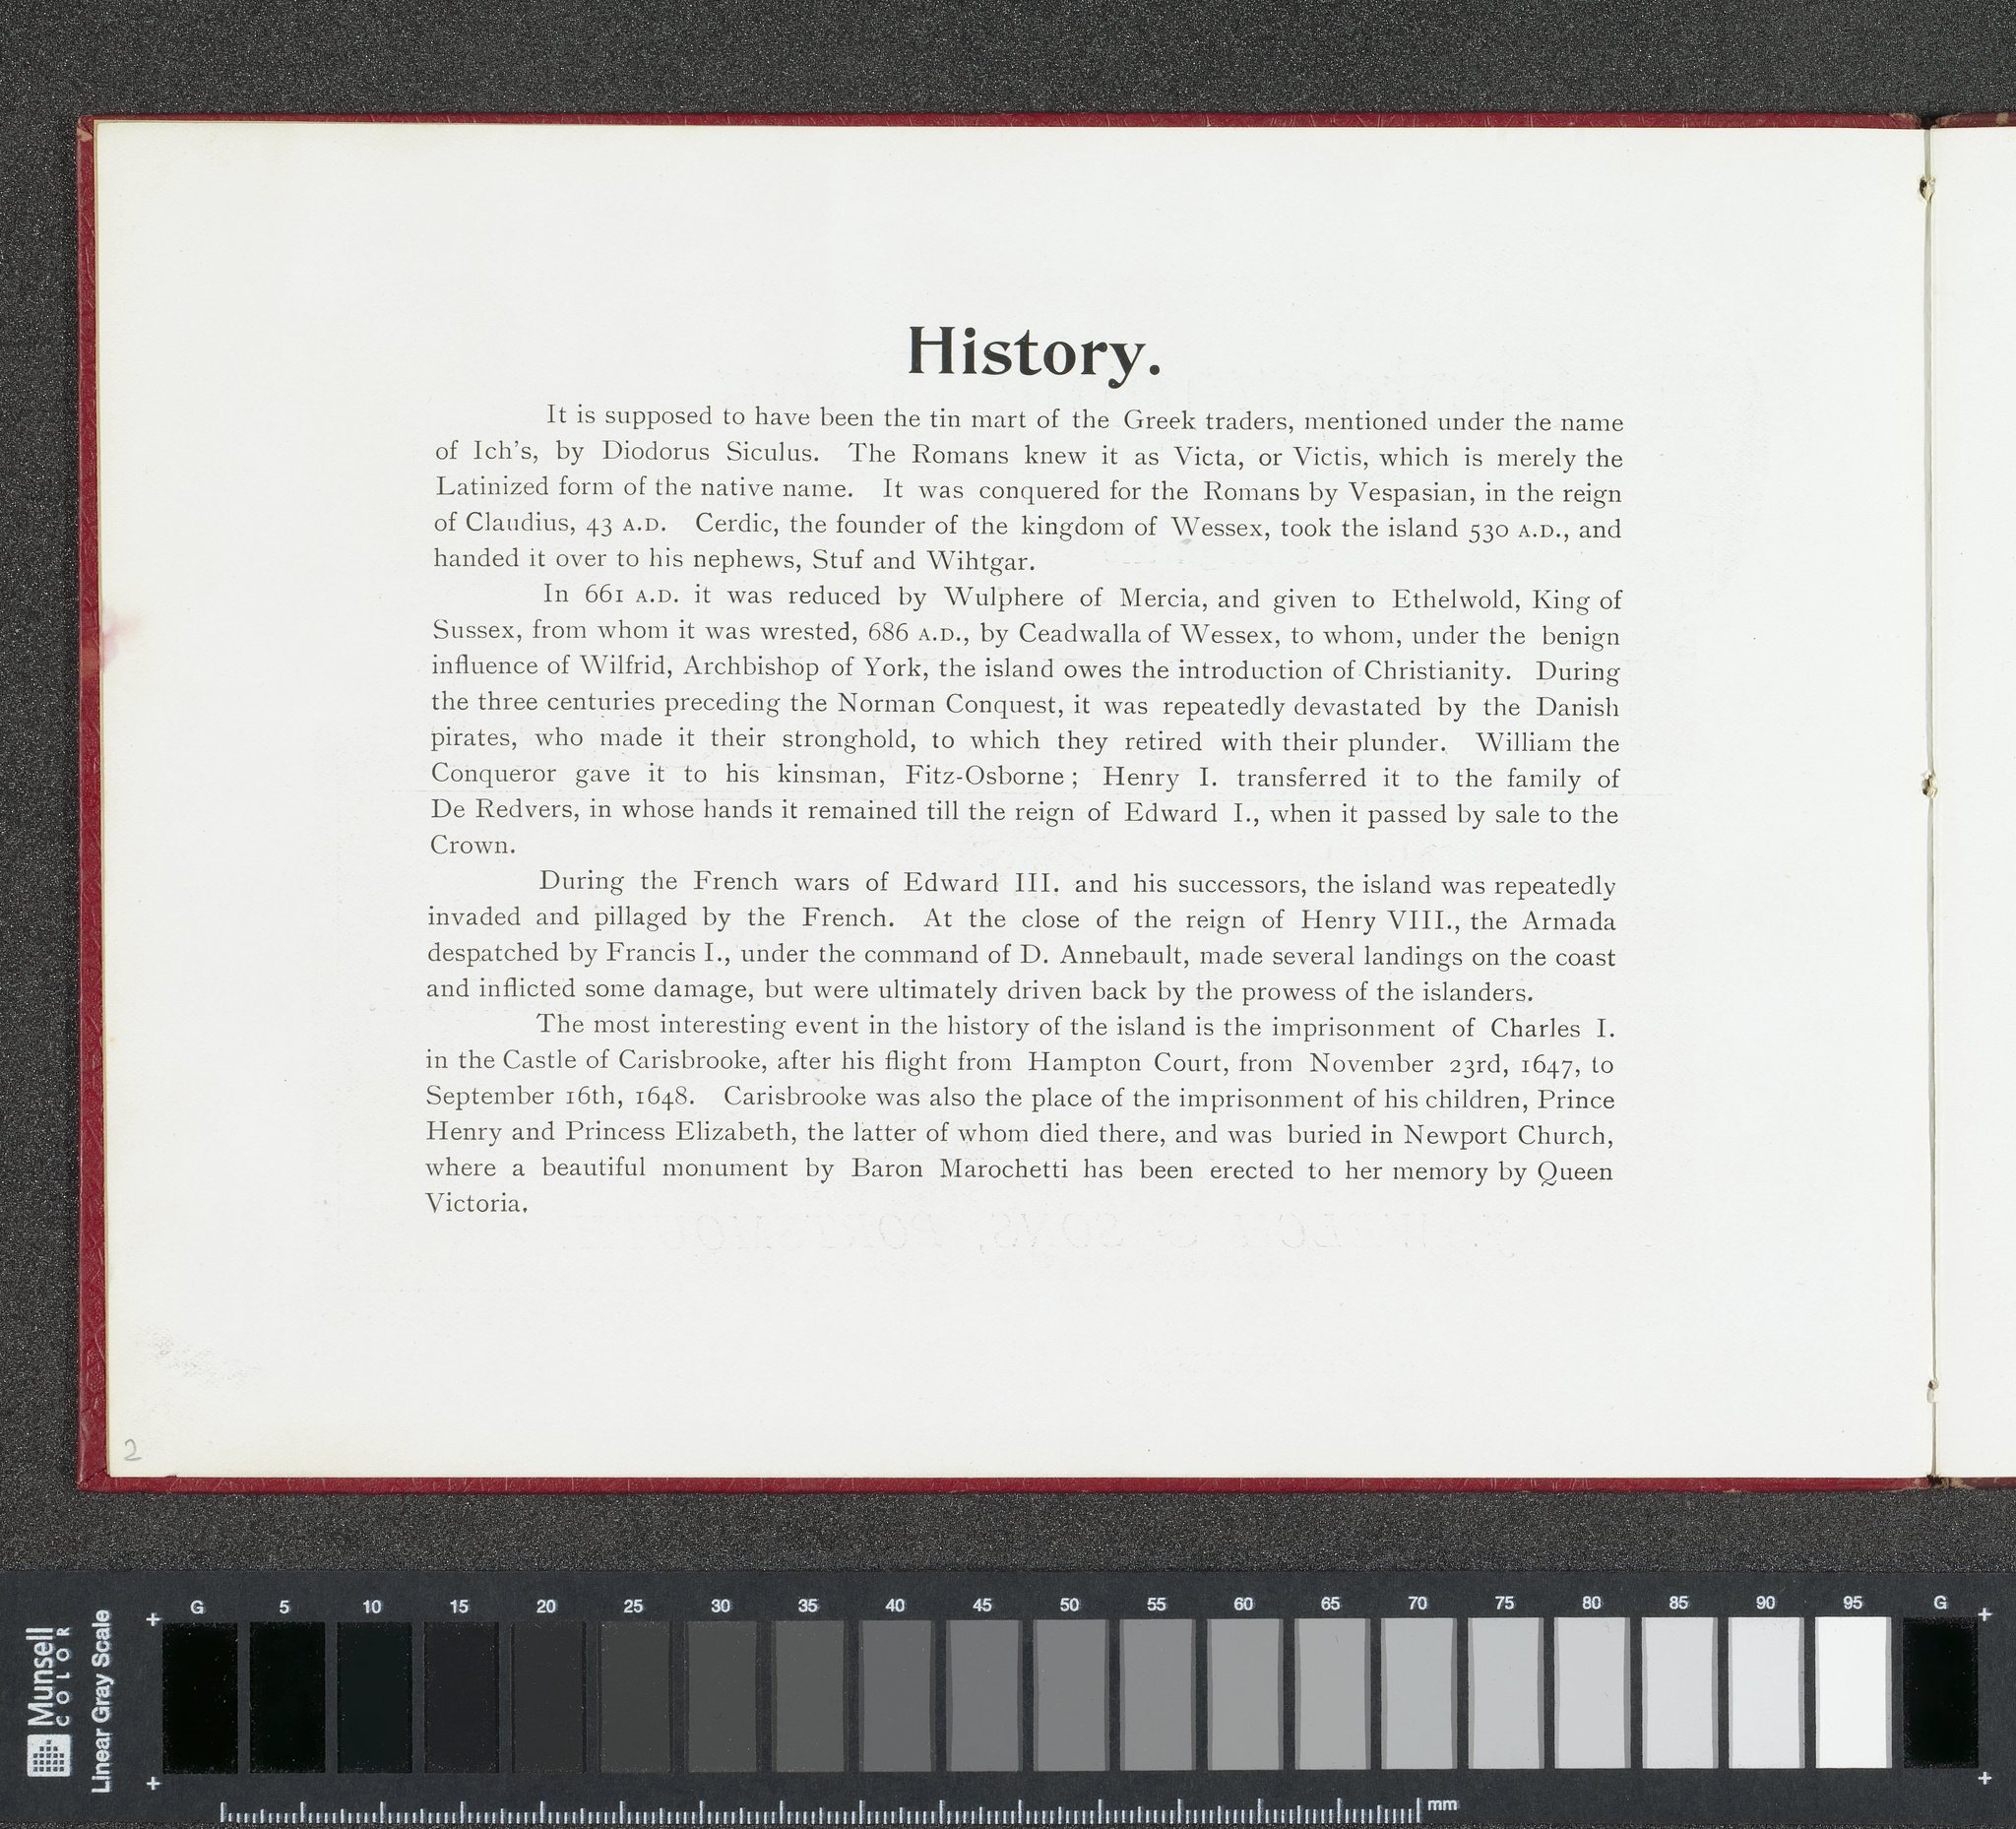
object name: page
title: History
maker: Anonymous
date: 1897-1930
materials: paper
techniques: printing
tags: historical events and situations; historical persons, travelling; tourism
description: Pagina 2 met een korte geschiedenis van het eiland Wight. Onderdeel van Fotografische reisreportage van het eiland Wight.